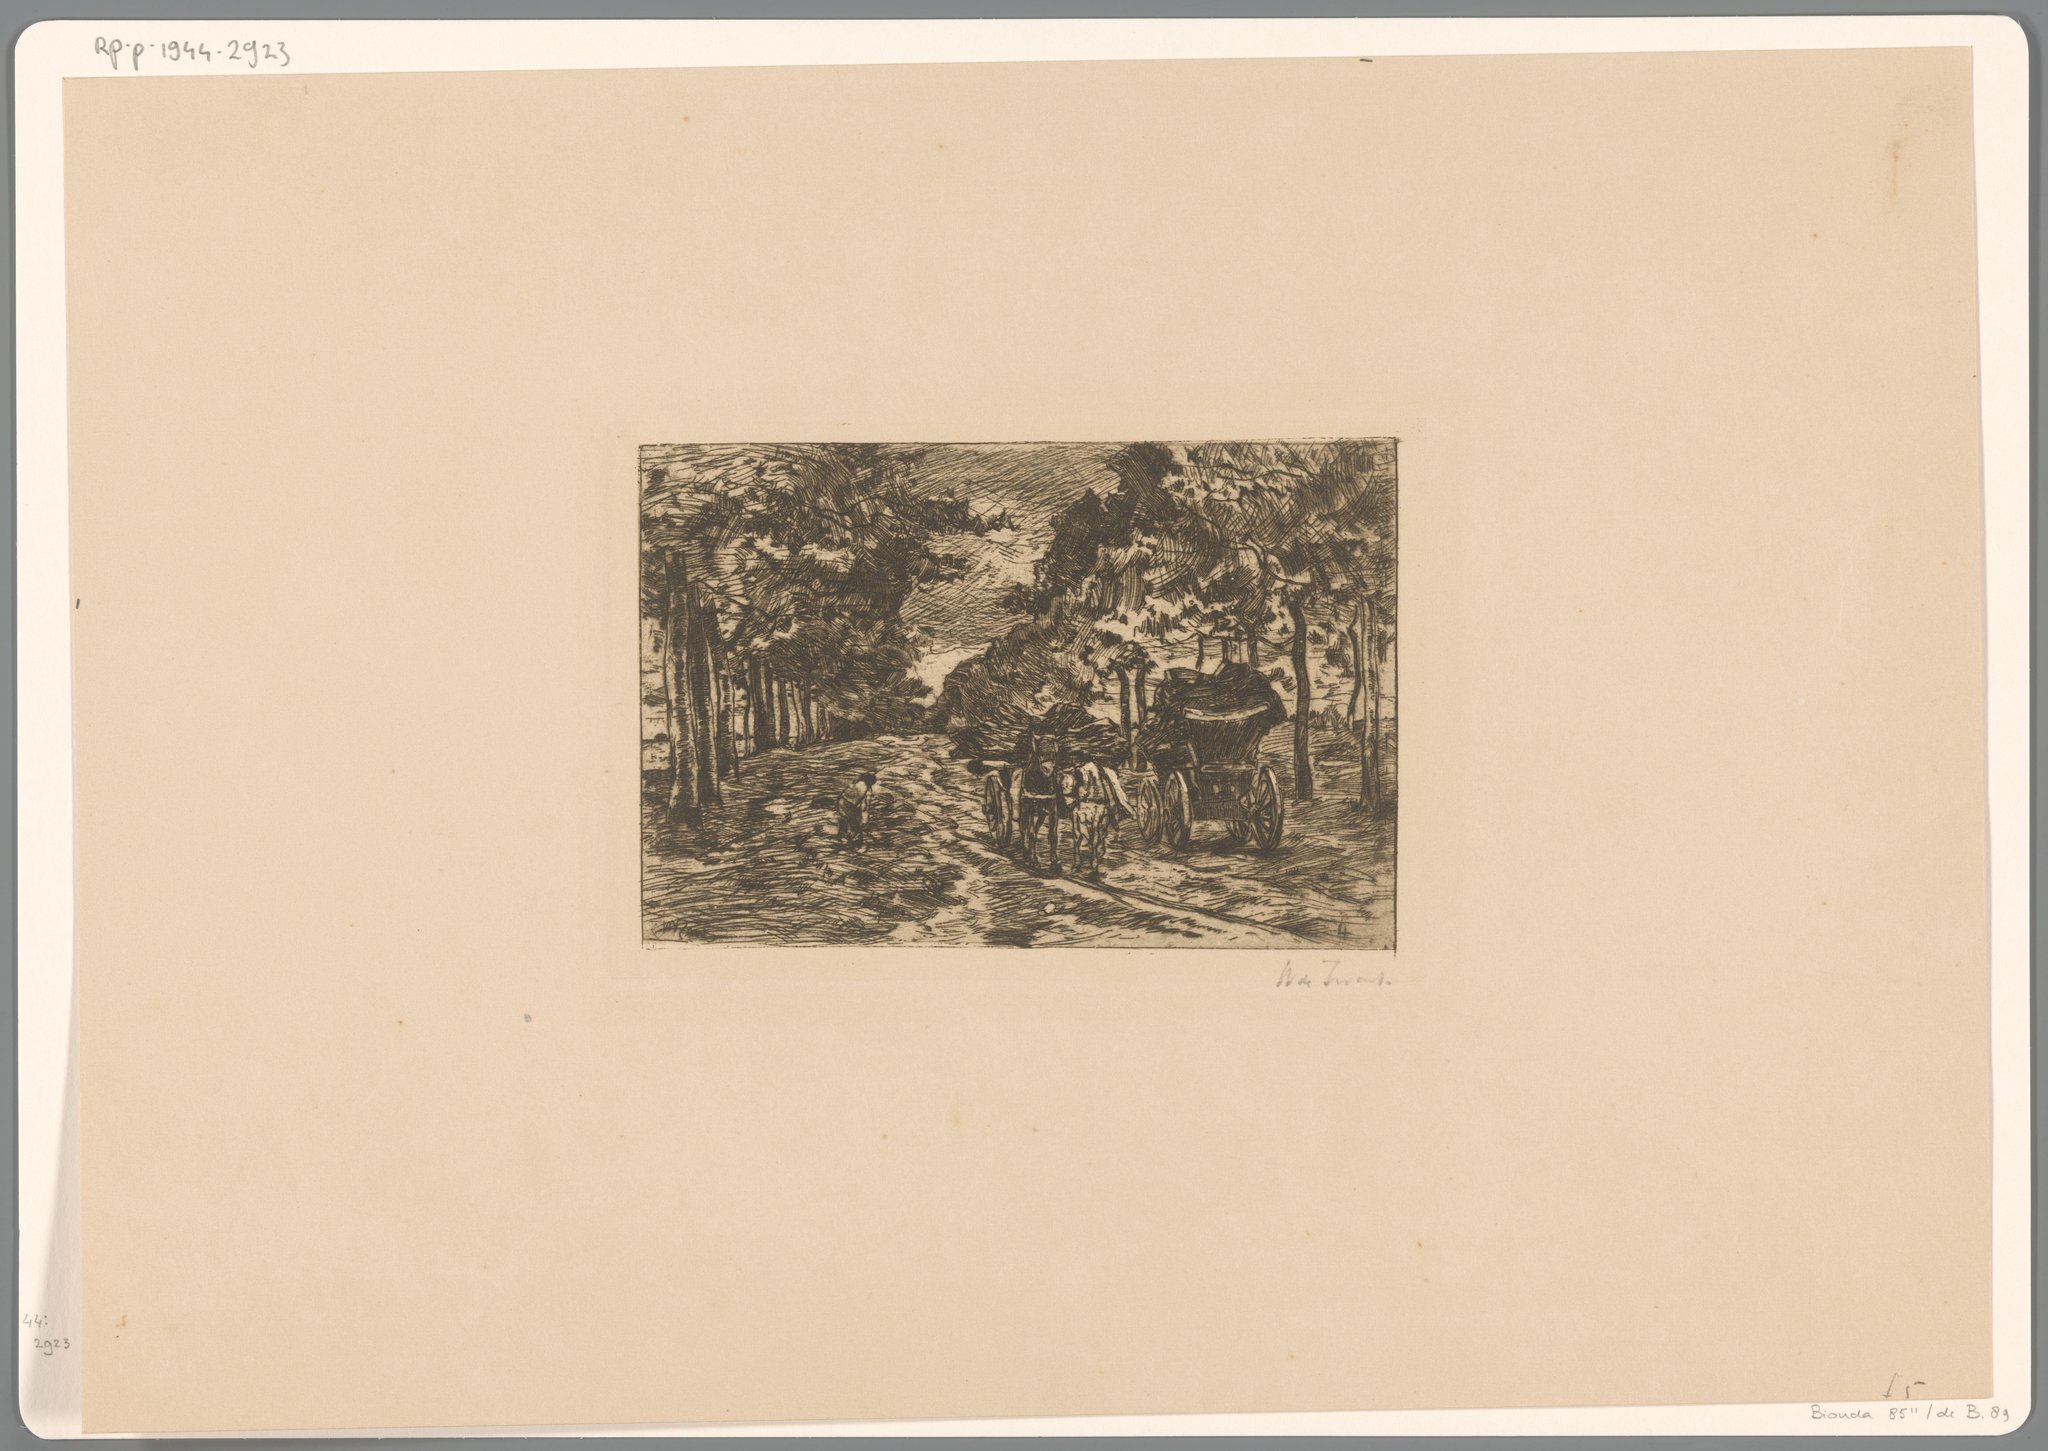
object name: print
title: Landweg met boerderijen en vrouw met kruiwagen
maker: willem de zwart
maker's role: draughtsman, painter, print maker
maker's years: 1862-1931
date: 1924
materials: paper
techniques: drypoint, etching, intaglio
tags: public road in village, wheelbarrow, farm or solitary house in landscape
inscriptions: collector's mark: Lugt 2760, collector's mark: Lugt 2228